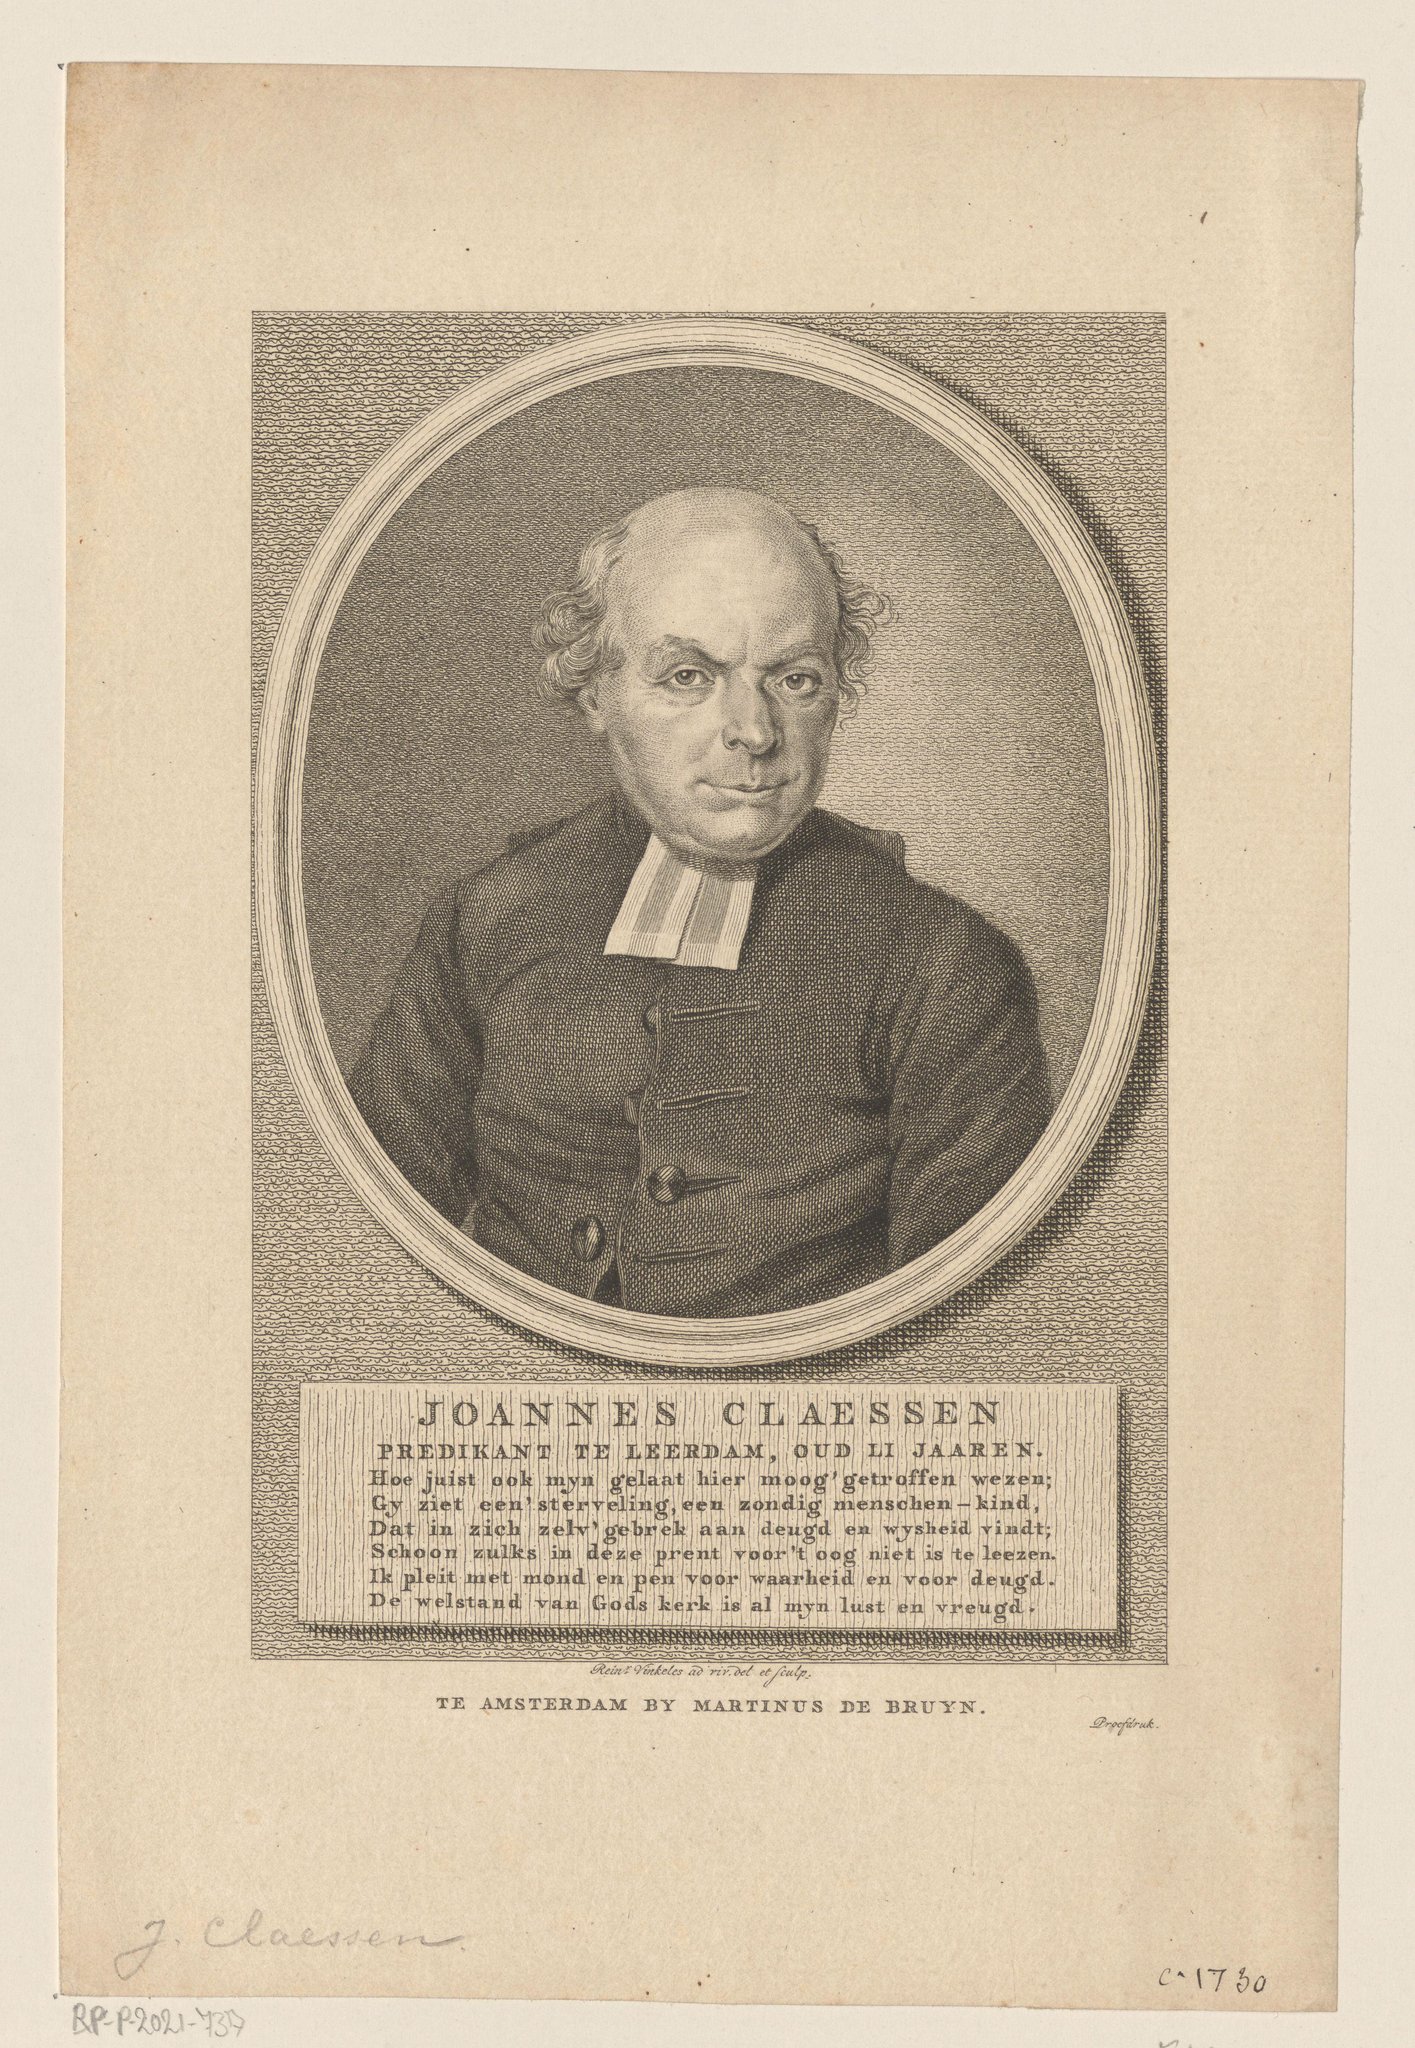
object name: print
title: Portret van Joannes Claessen op 51-jarige leeftijd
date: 1785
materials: paper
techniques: etching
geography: amsterdam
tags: maastricht, historical persons